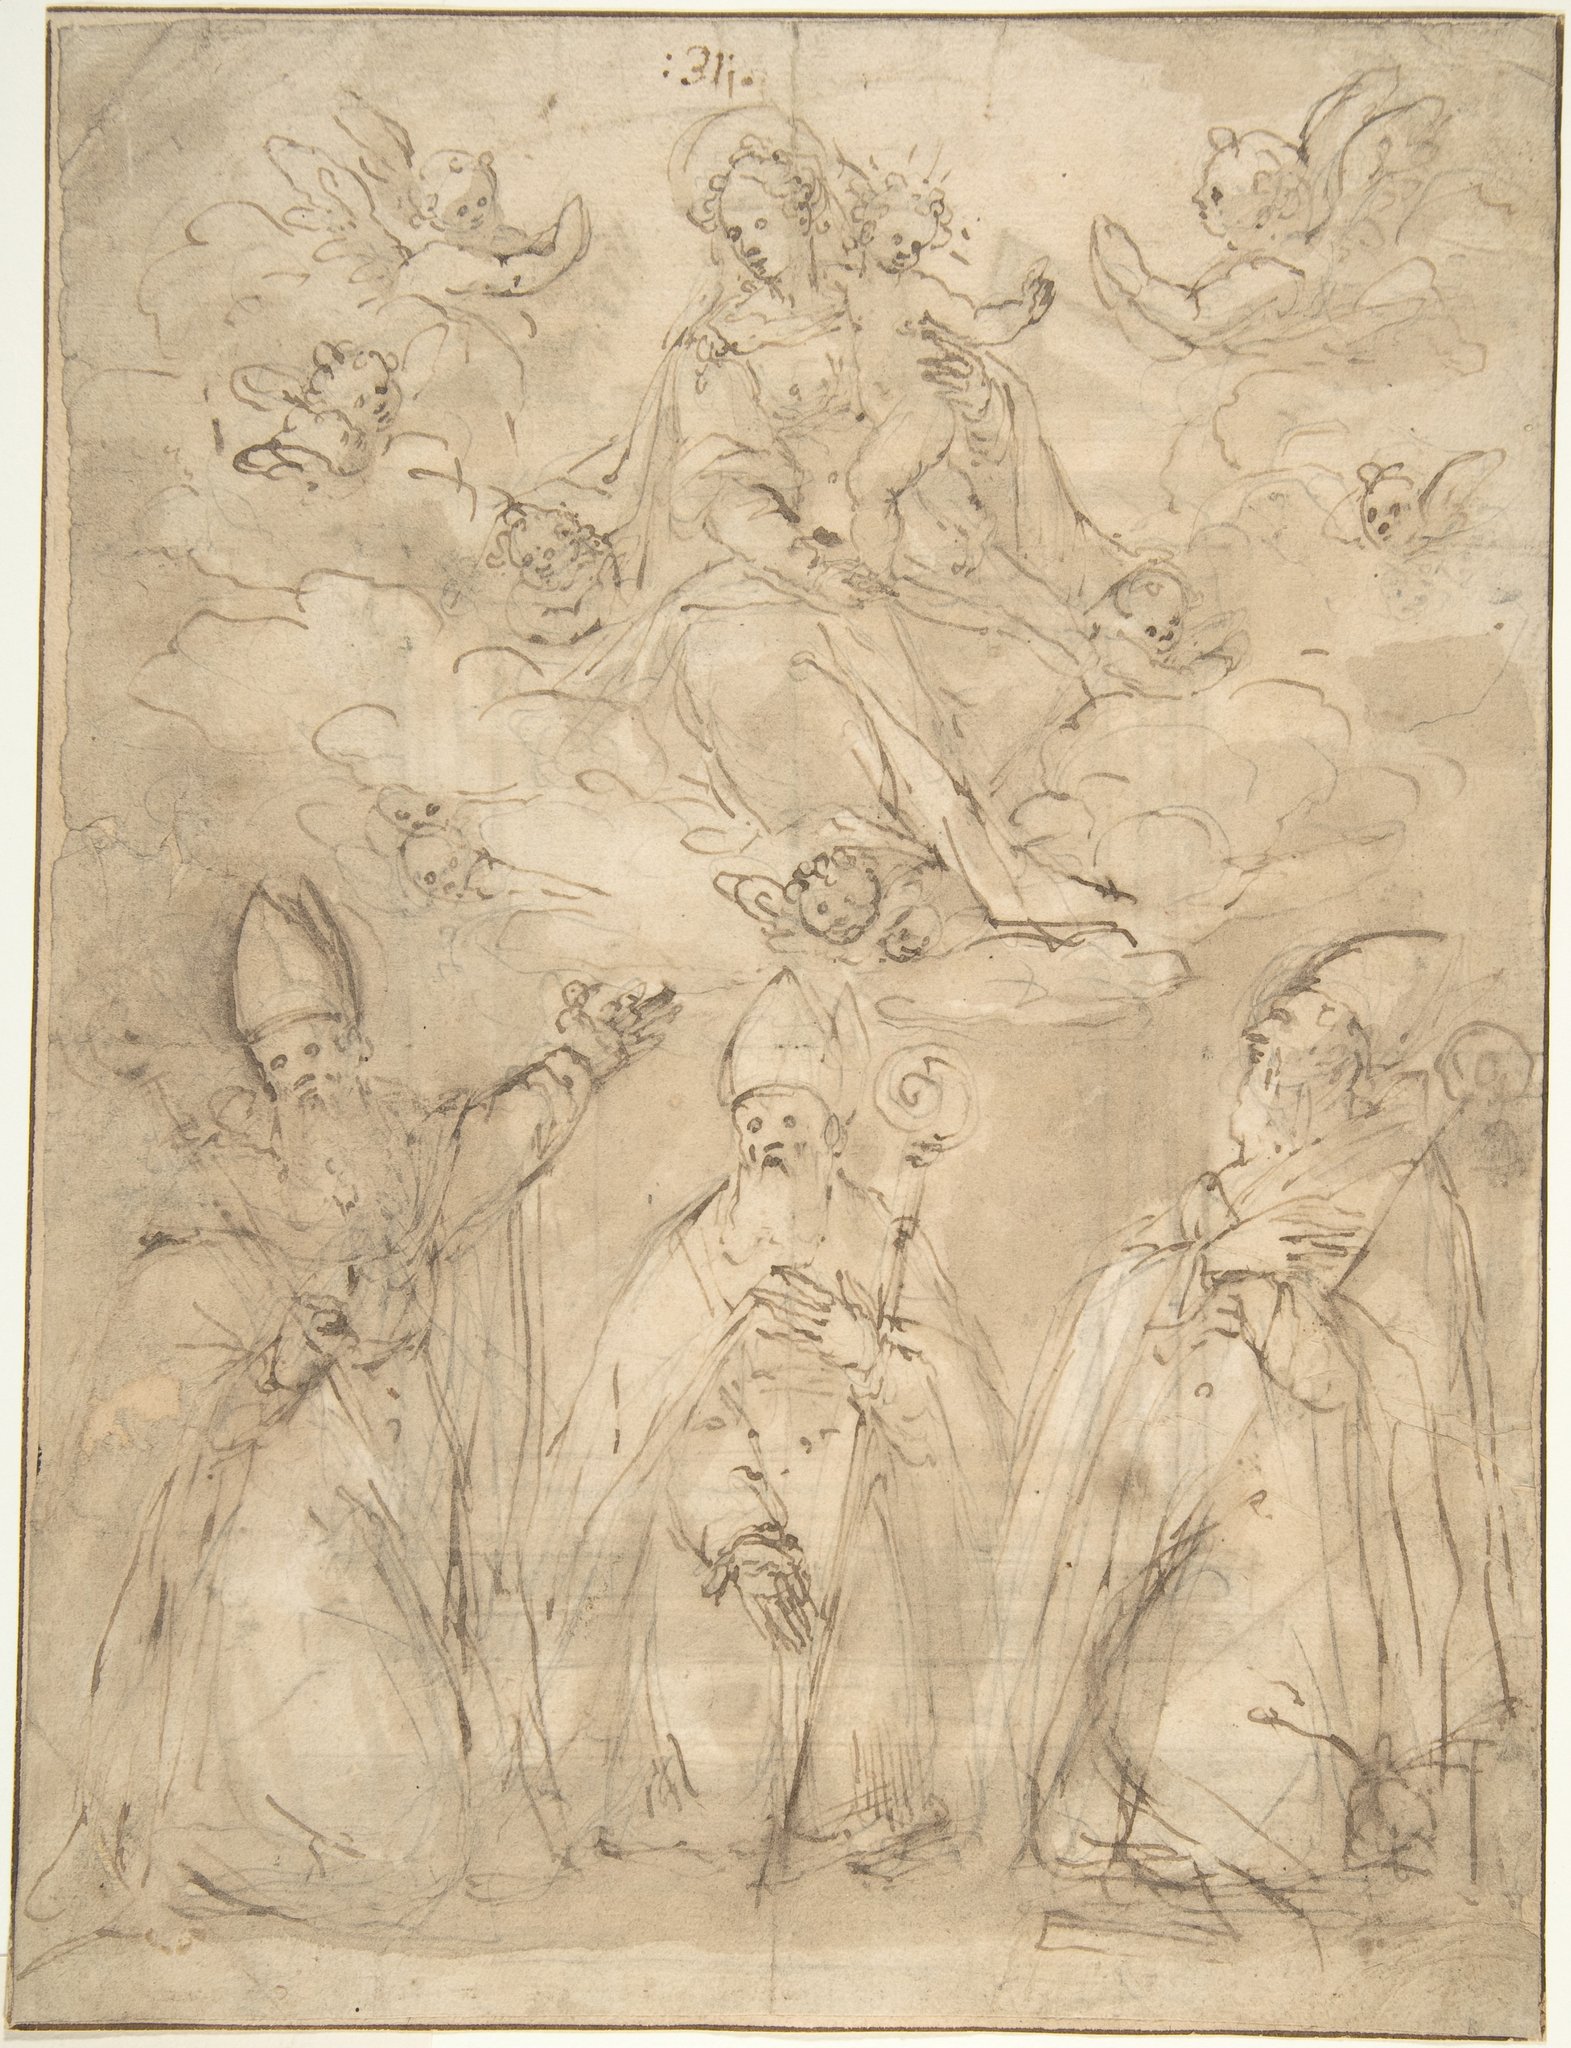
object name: drawing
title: Virgin and Child Worshipped by Three Bishops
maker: anonymous, italian, 16th century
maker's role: artist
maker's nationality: italian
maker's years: 1550-1600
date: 1501-1600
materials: chalk, ink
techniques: pen, wash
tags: angels,bishops,madonna and child,praying